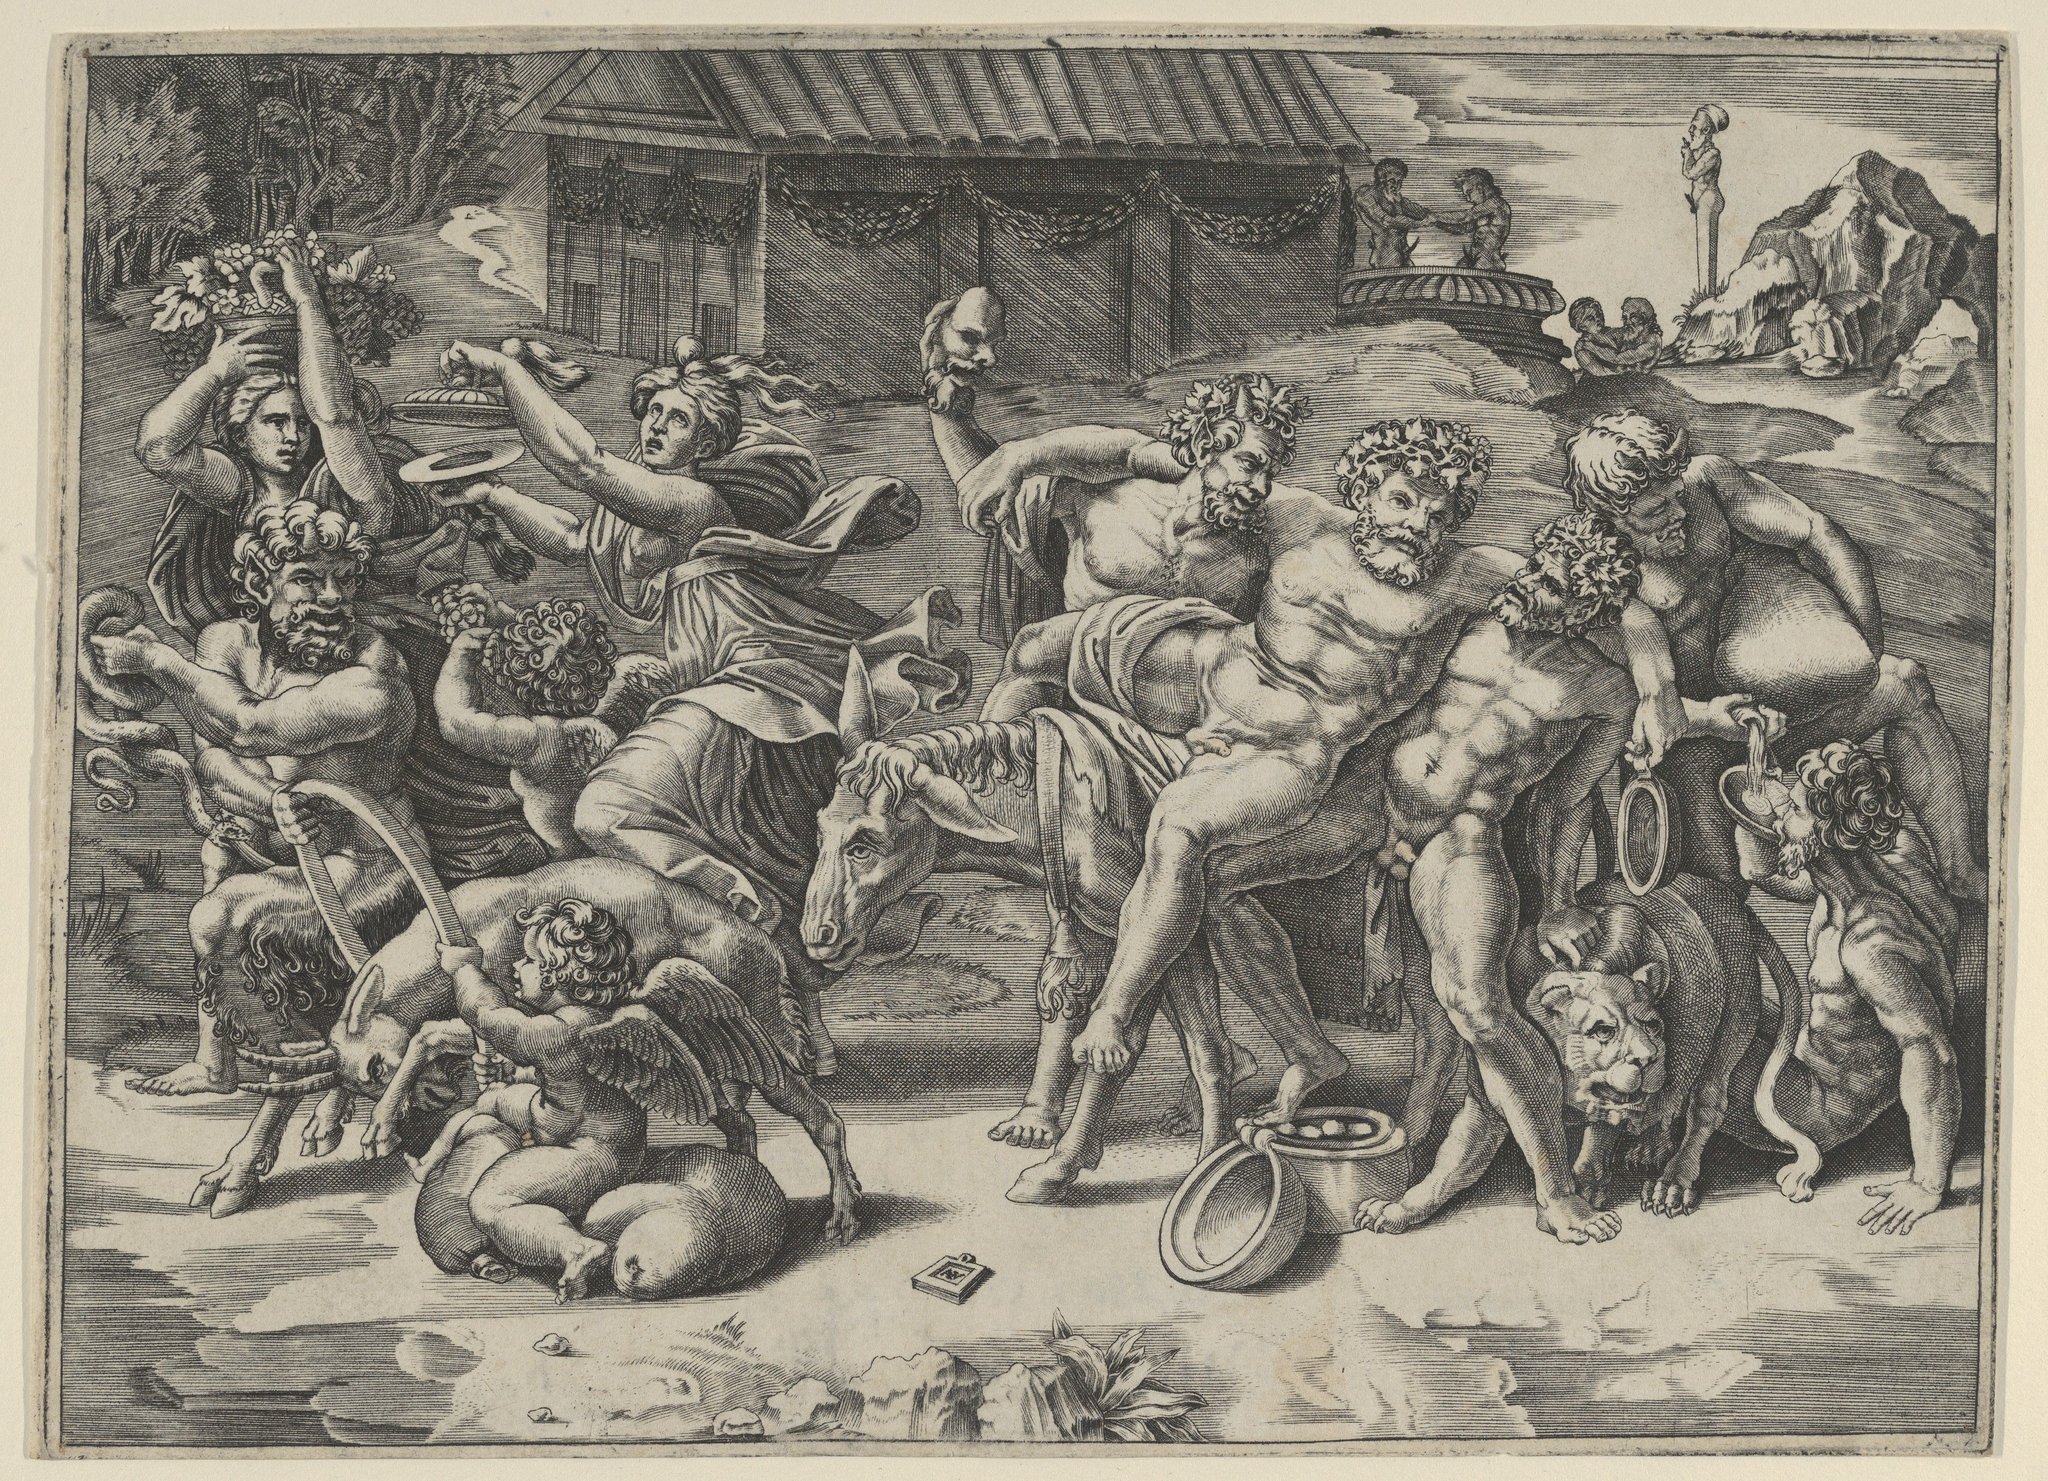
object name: print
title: The procession of Silenus who is carried on an ass preceeded by a bacchant playing the cymbals and other figures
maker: agostino veneziano (agostino dei musi)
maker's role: artist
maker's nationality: italian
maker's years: 1490-1536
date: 1531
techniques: engraving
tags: musical instruments,male nudes,silenus,bacchantes,goats,lions